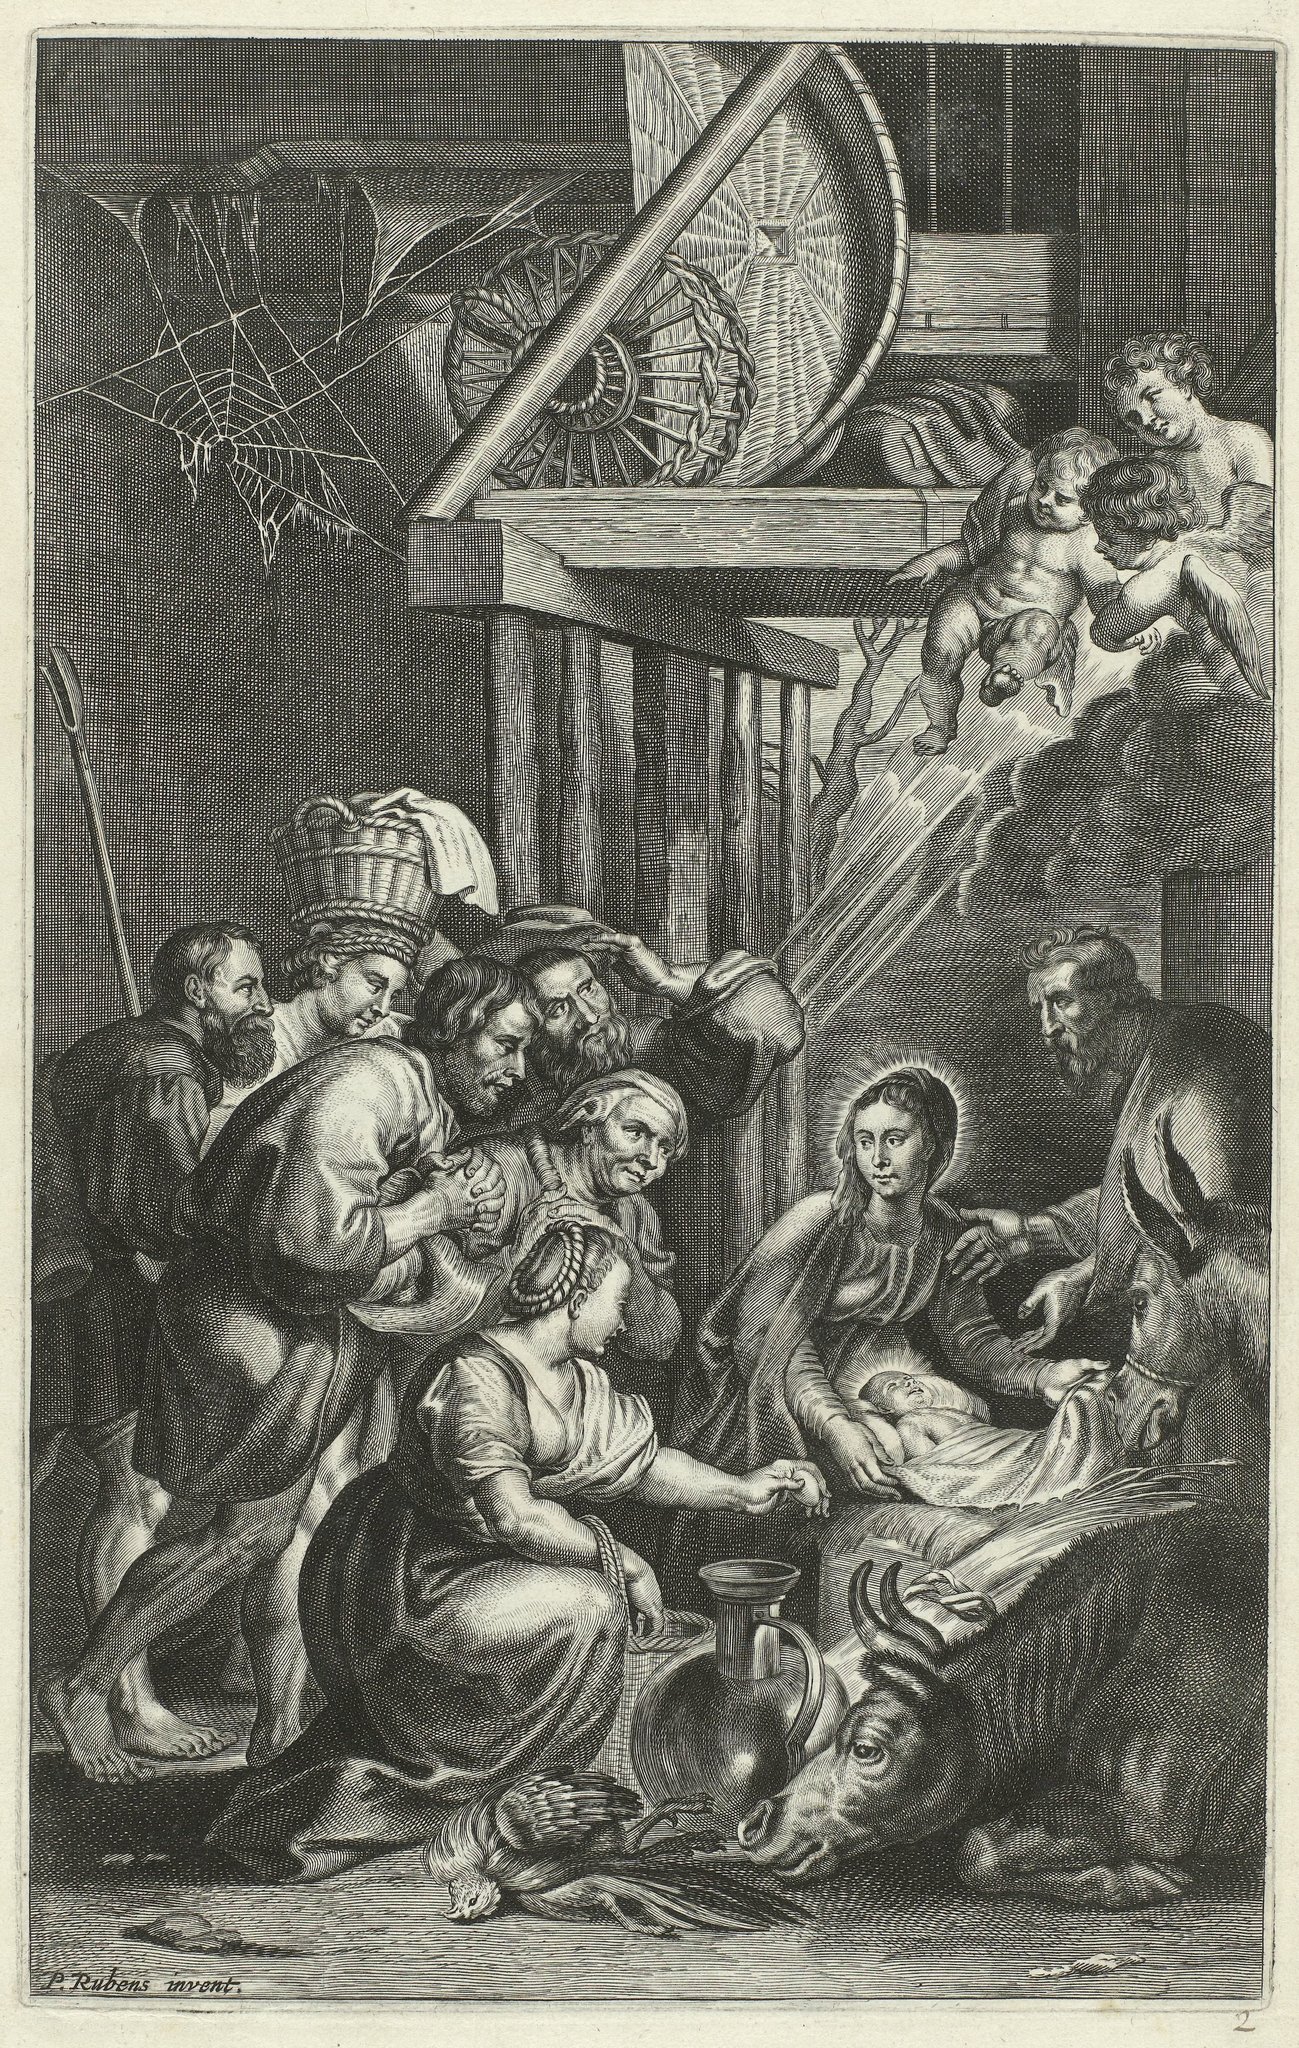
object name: album leaf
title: Leven van Christus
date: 1600-1652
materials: paper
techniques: engraving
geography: antwerp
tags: adoration of the christ-child ~ christ's birth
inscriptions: collector's mark: Lugt 2760, inscription: ‘2’, collector's mark: Lugt 2228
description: Maria met het Kind, Jozef, de os en de ezel, in een schuur. Boven hen drie engeltjes. Links een groepje mannen en vrouwen in aanbidding. Op de voorgrond ligt een kip. De prent maakt deel uit van een album.